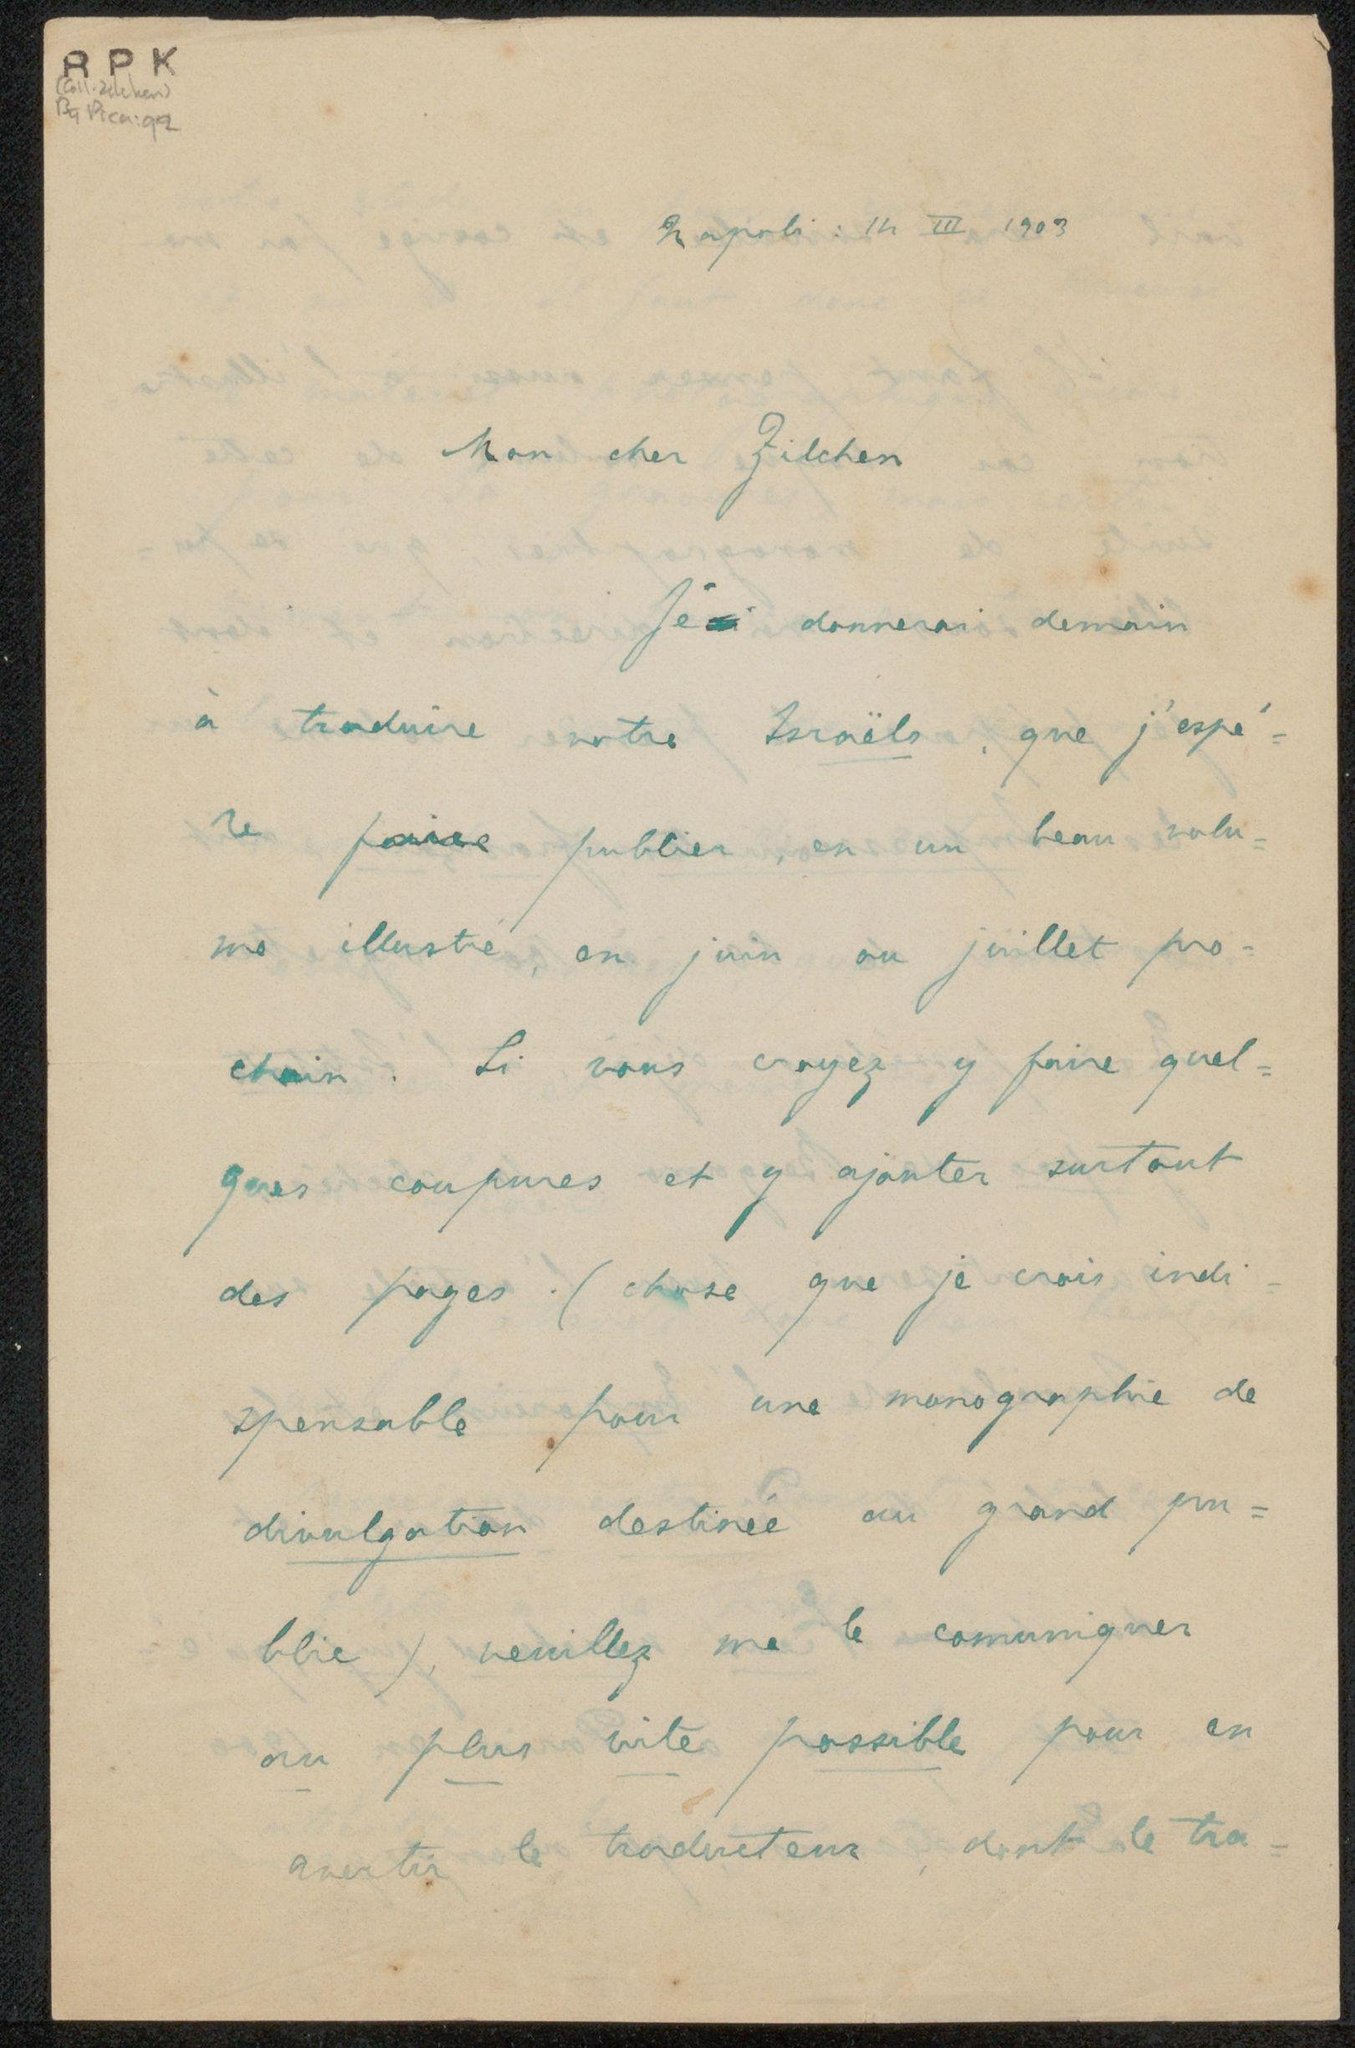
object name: letter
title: Brief aan Philip Zilcken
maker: vittorio pica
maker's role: criticus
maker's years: 1864-1930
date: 1903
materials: ink, paper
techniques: pen, writing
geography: naples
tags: painter, draughtsman, jozef israëls, james ensor, print maker, edvard munch, jan toorop, aubrey beardsley, philip zilcken, printed matter, paris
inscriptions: collector's mark: ‘RPK’